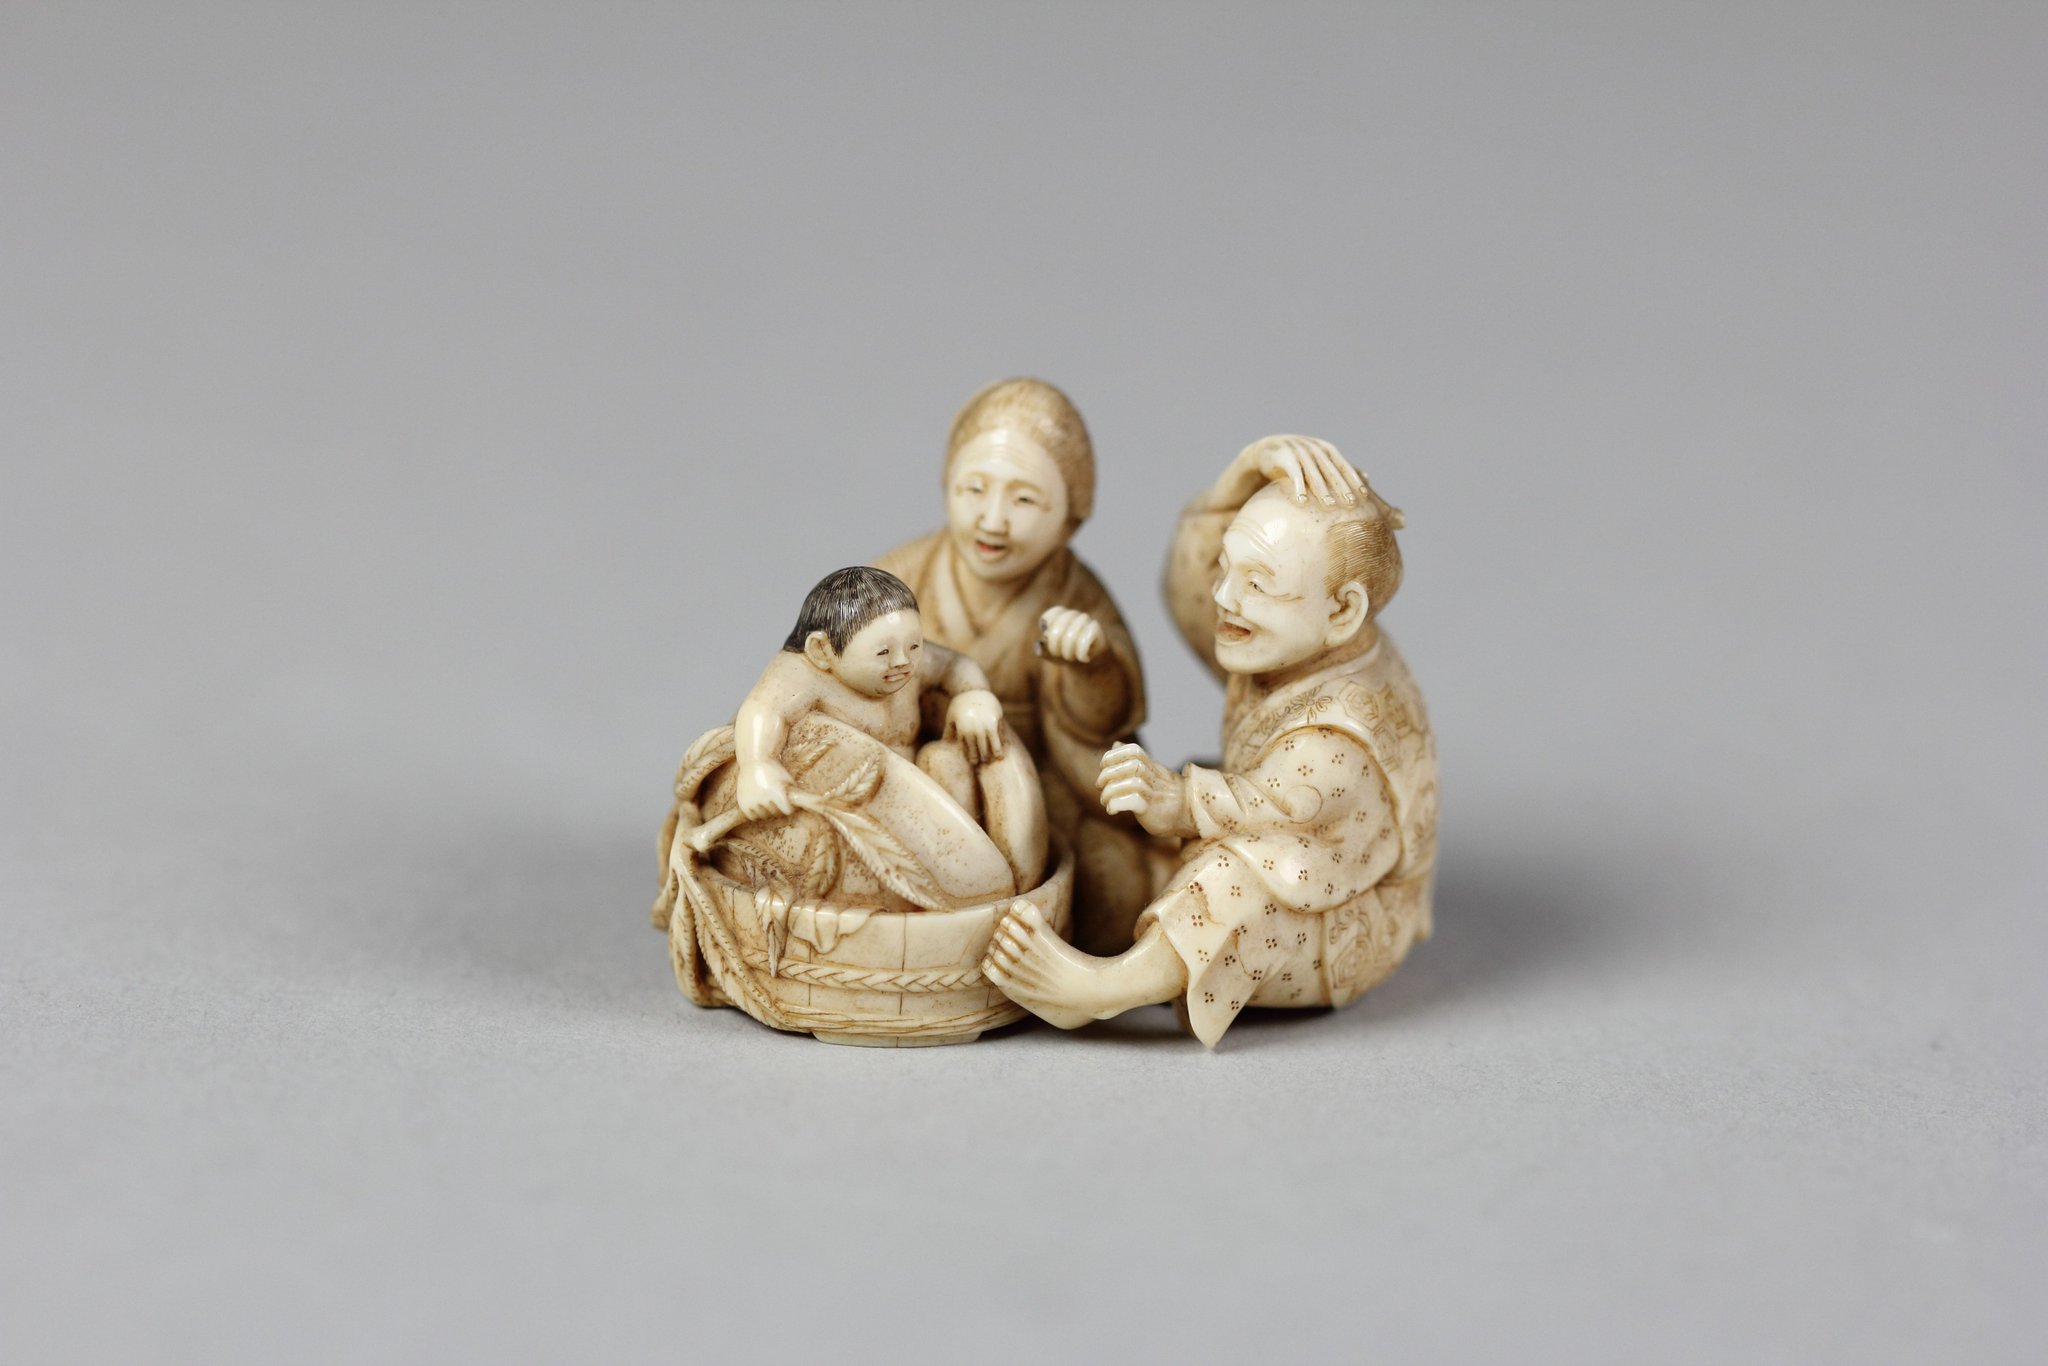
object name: netsuke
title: Man, Woman and Child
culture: japanese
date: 1801-1900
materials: ivory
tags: children,men,women